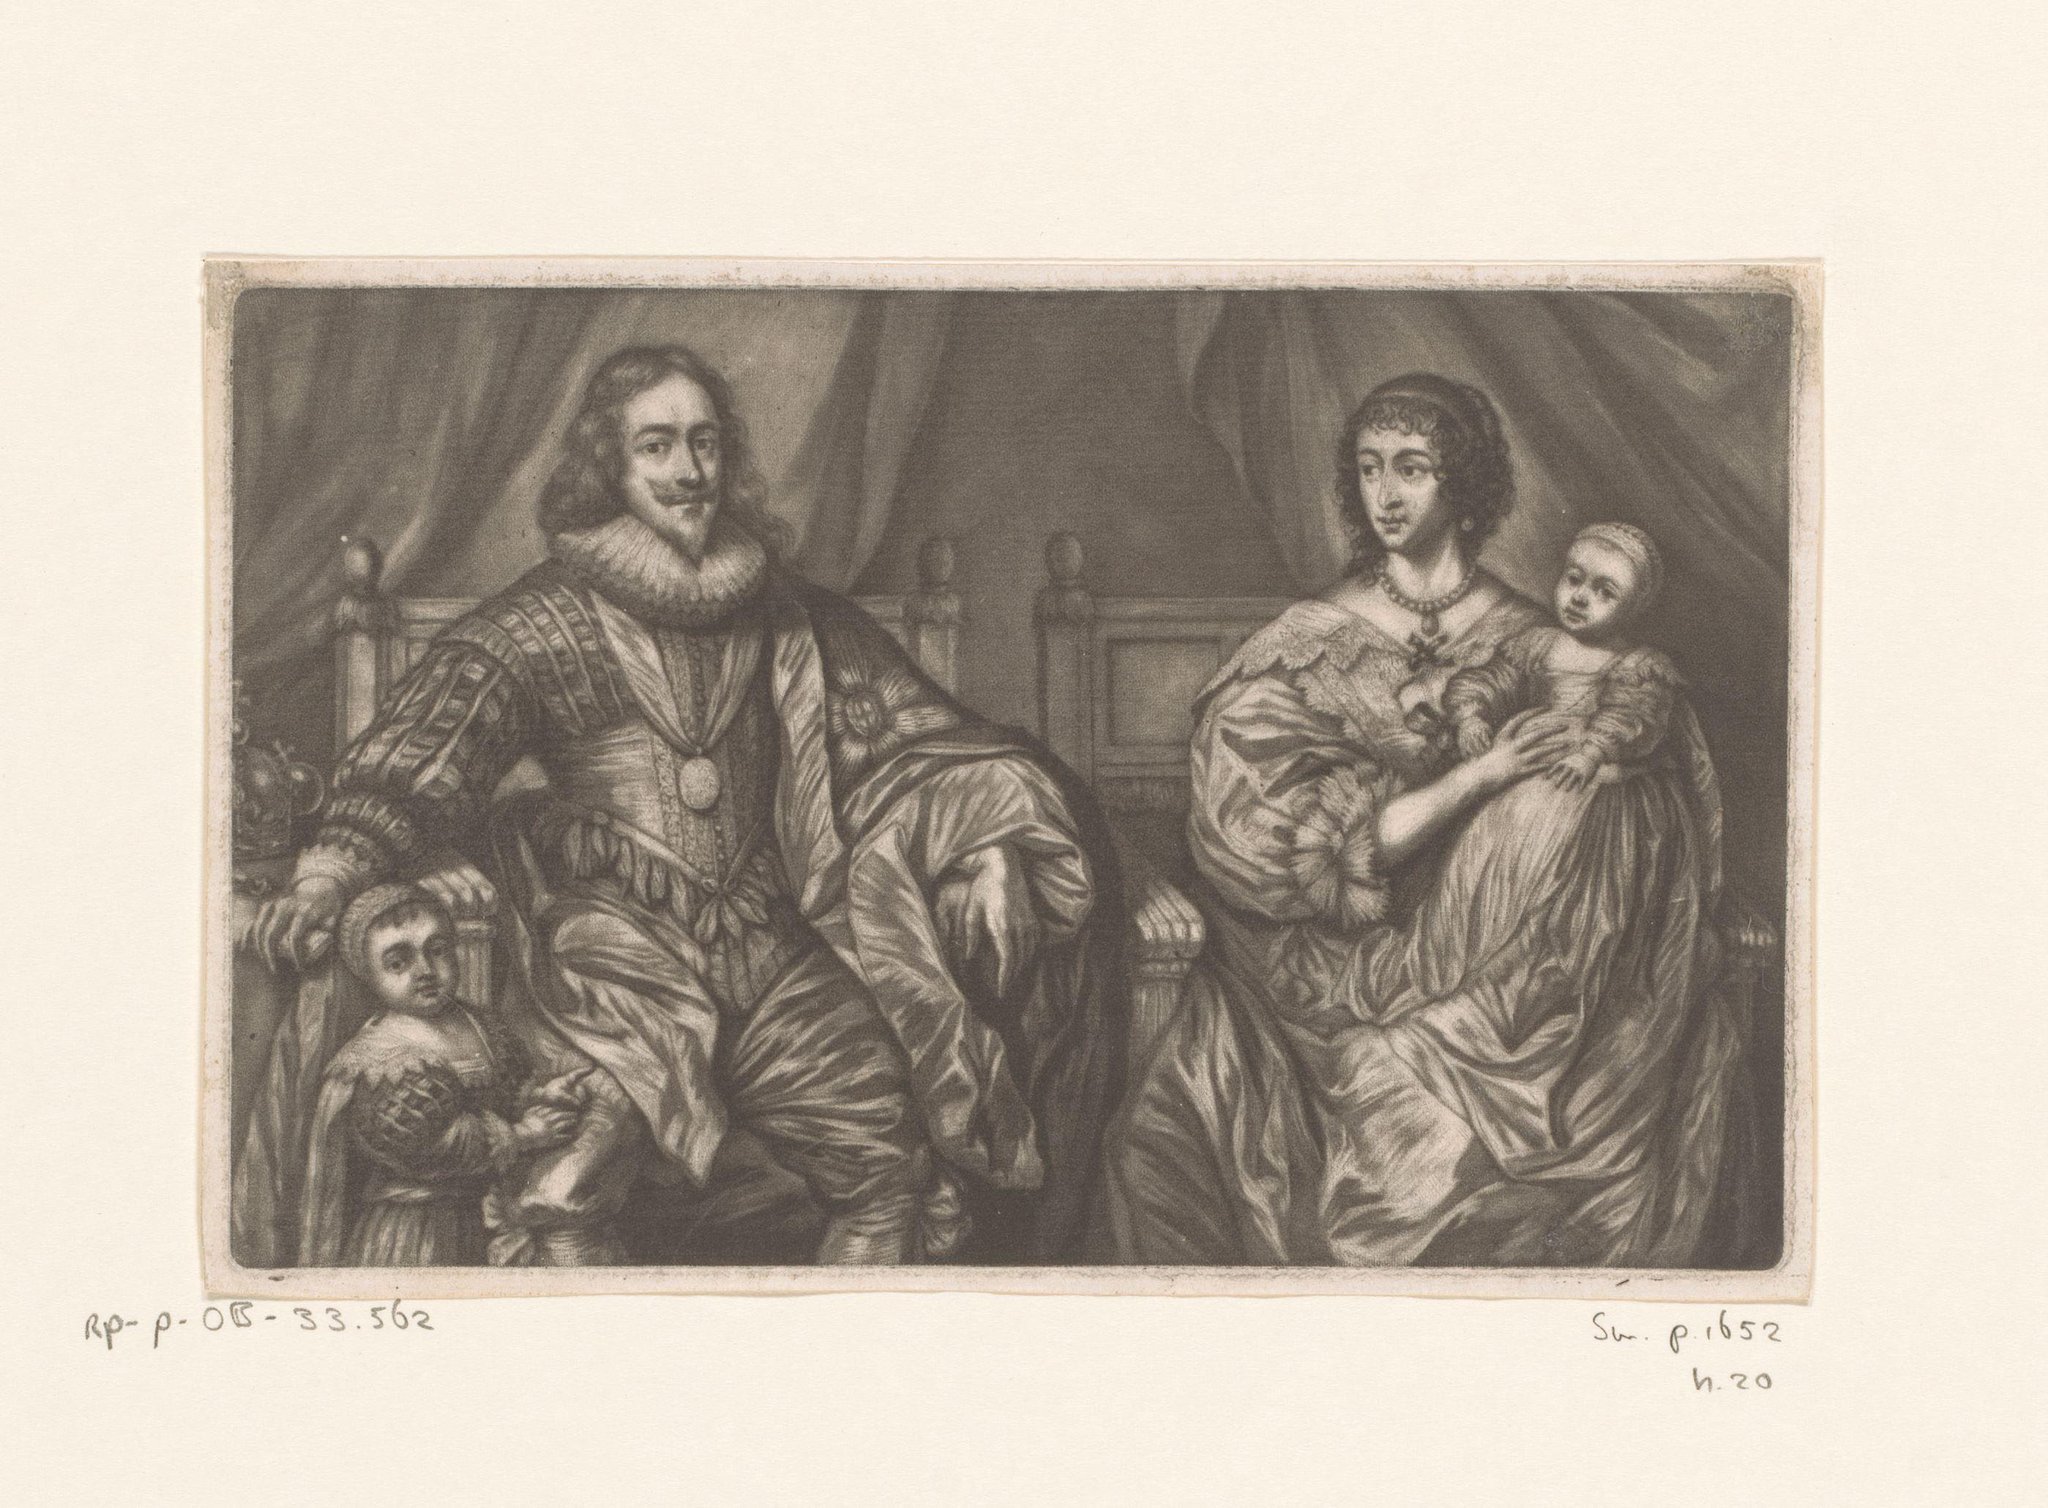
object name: print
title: Portret van Karel I van Engeland met Henriëtta Maria en hun kinderen Karel en Maria Henriëtte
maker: Anonymous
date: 1670-1700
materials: paper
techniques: mezzotint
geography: england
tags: henriëtta maria van frankrijk (koningin van engeland, schotland en ierland), london, mary henrietta stuart, karel i (koning van engeland), karel ii (koning van engeland), historical persons - bb - woman, historical persons, children (first degree family relationships), parents (first degree family relationships)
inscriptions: collector's mark: Lugt 240